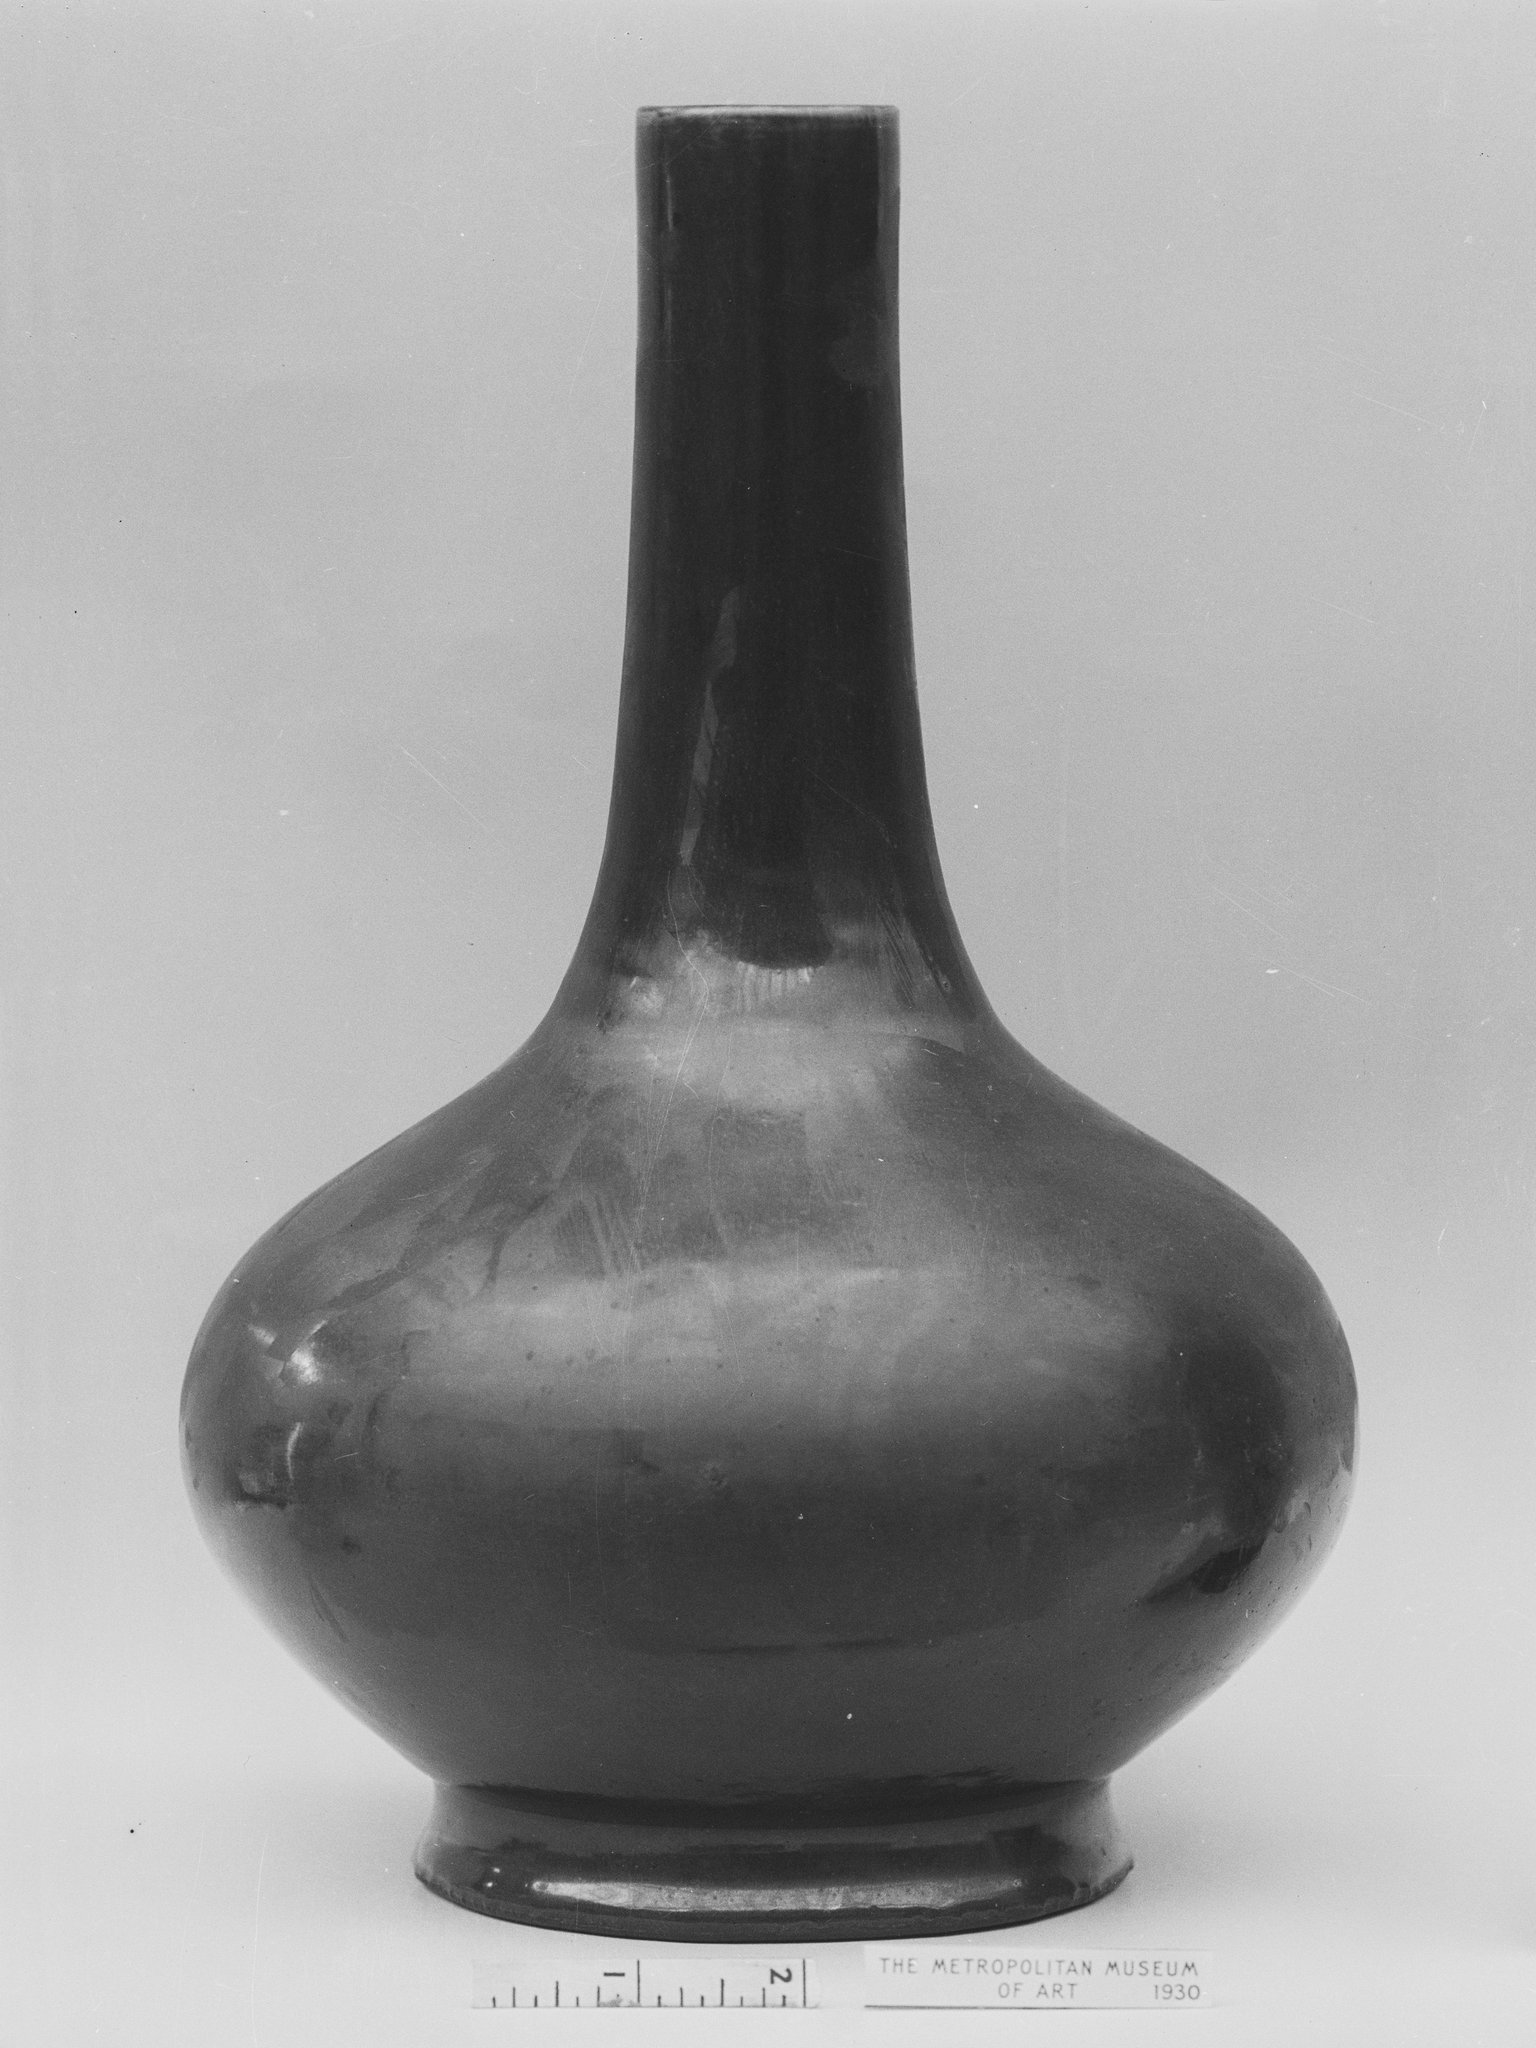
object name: bottle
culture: chinese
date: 1736-1795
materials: porcelain